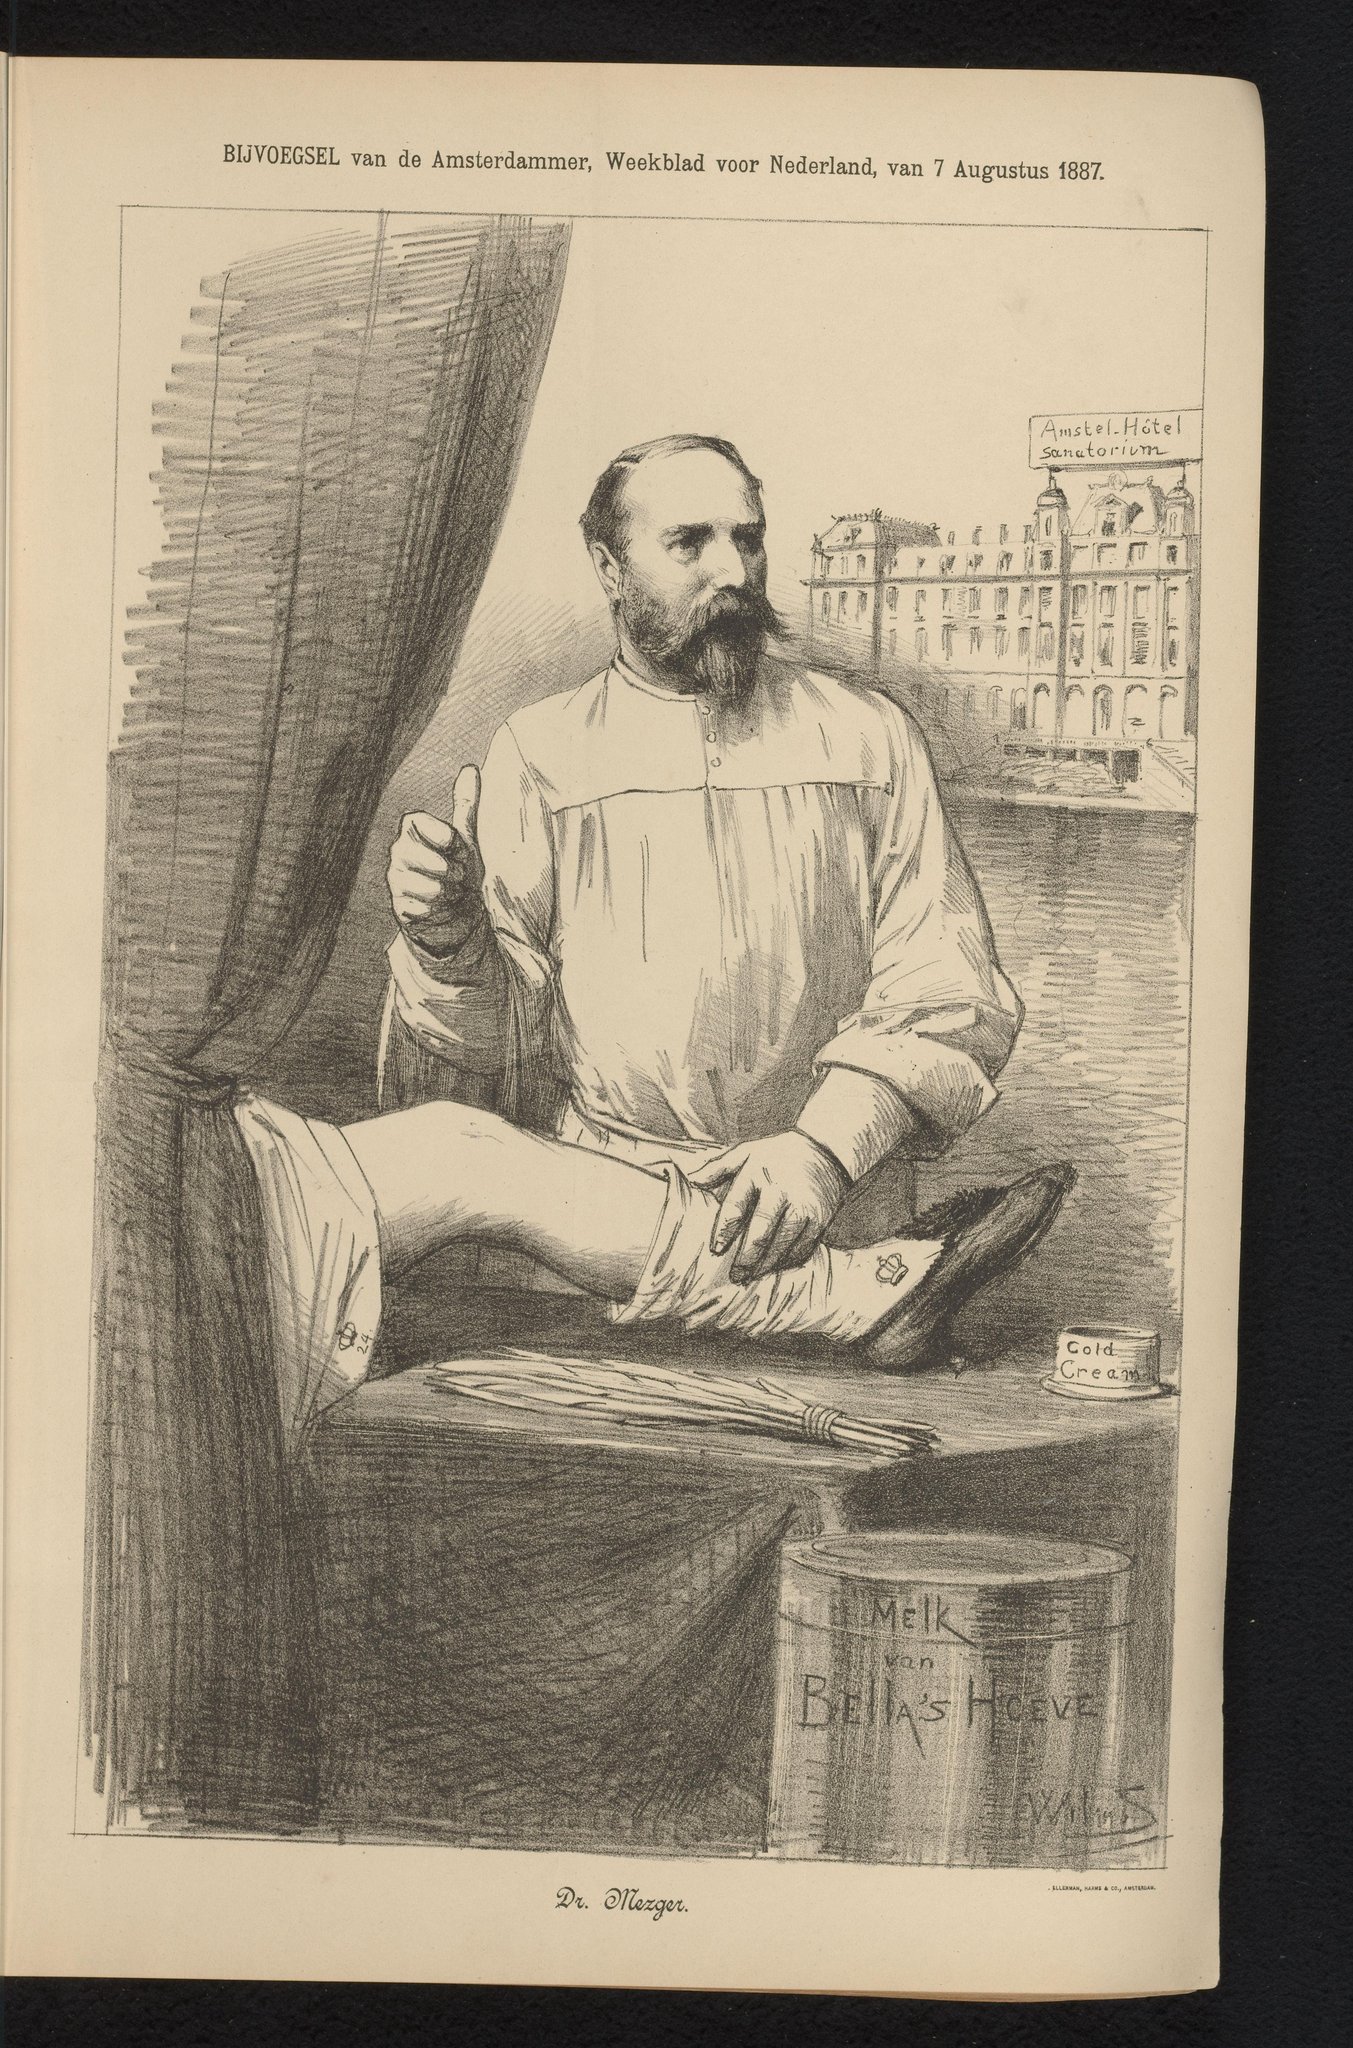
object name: print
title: Dr. Mezger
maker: willem steelink (ii)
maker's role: draughtsman, print maker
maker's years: 1856-1928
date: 1887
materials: paper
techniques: lithograph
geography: netherlands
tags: amsterdam, massage ~ medical treatment, historical persons, physician, doctor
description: Portret van de arts en masseur Johann Georg Mezger. Afgebeeld terwijl hij het been van een vrouw, mogelijk de koninklijke patiënte prinses Marie, masseert. Op de achtergrond het Amstel Hotel waar Mezger patiënten behandelde.